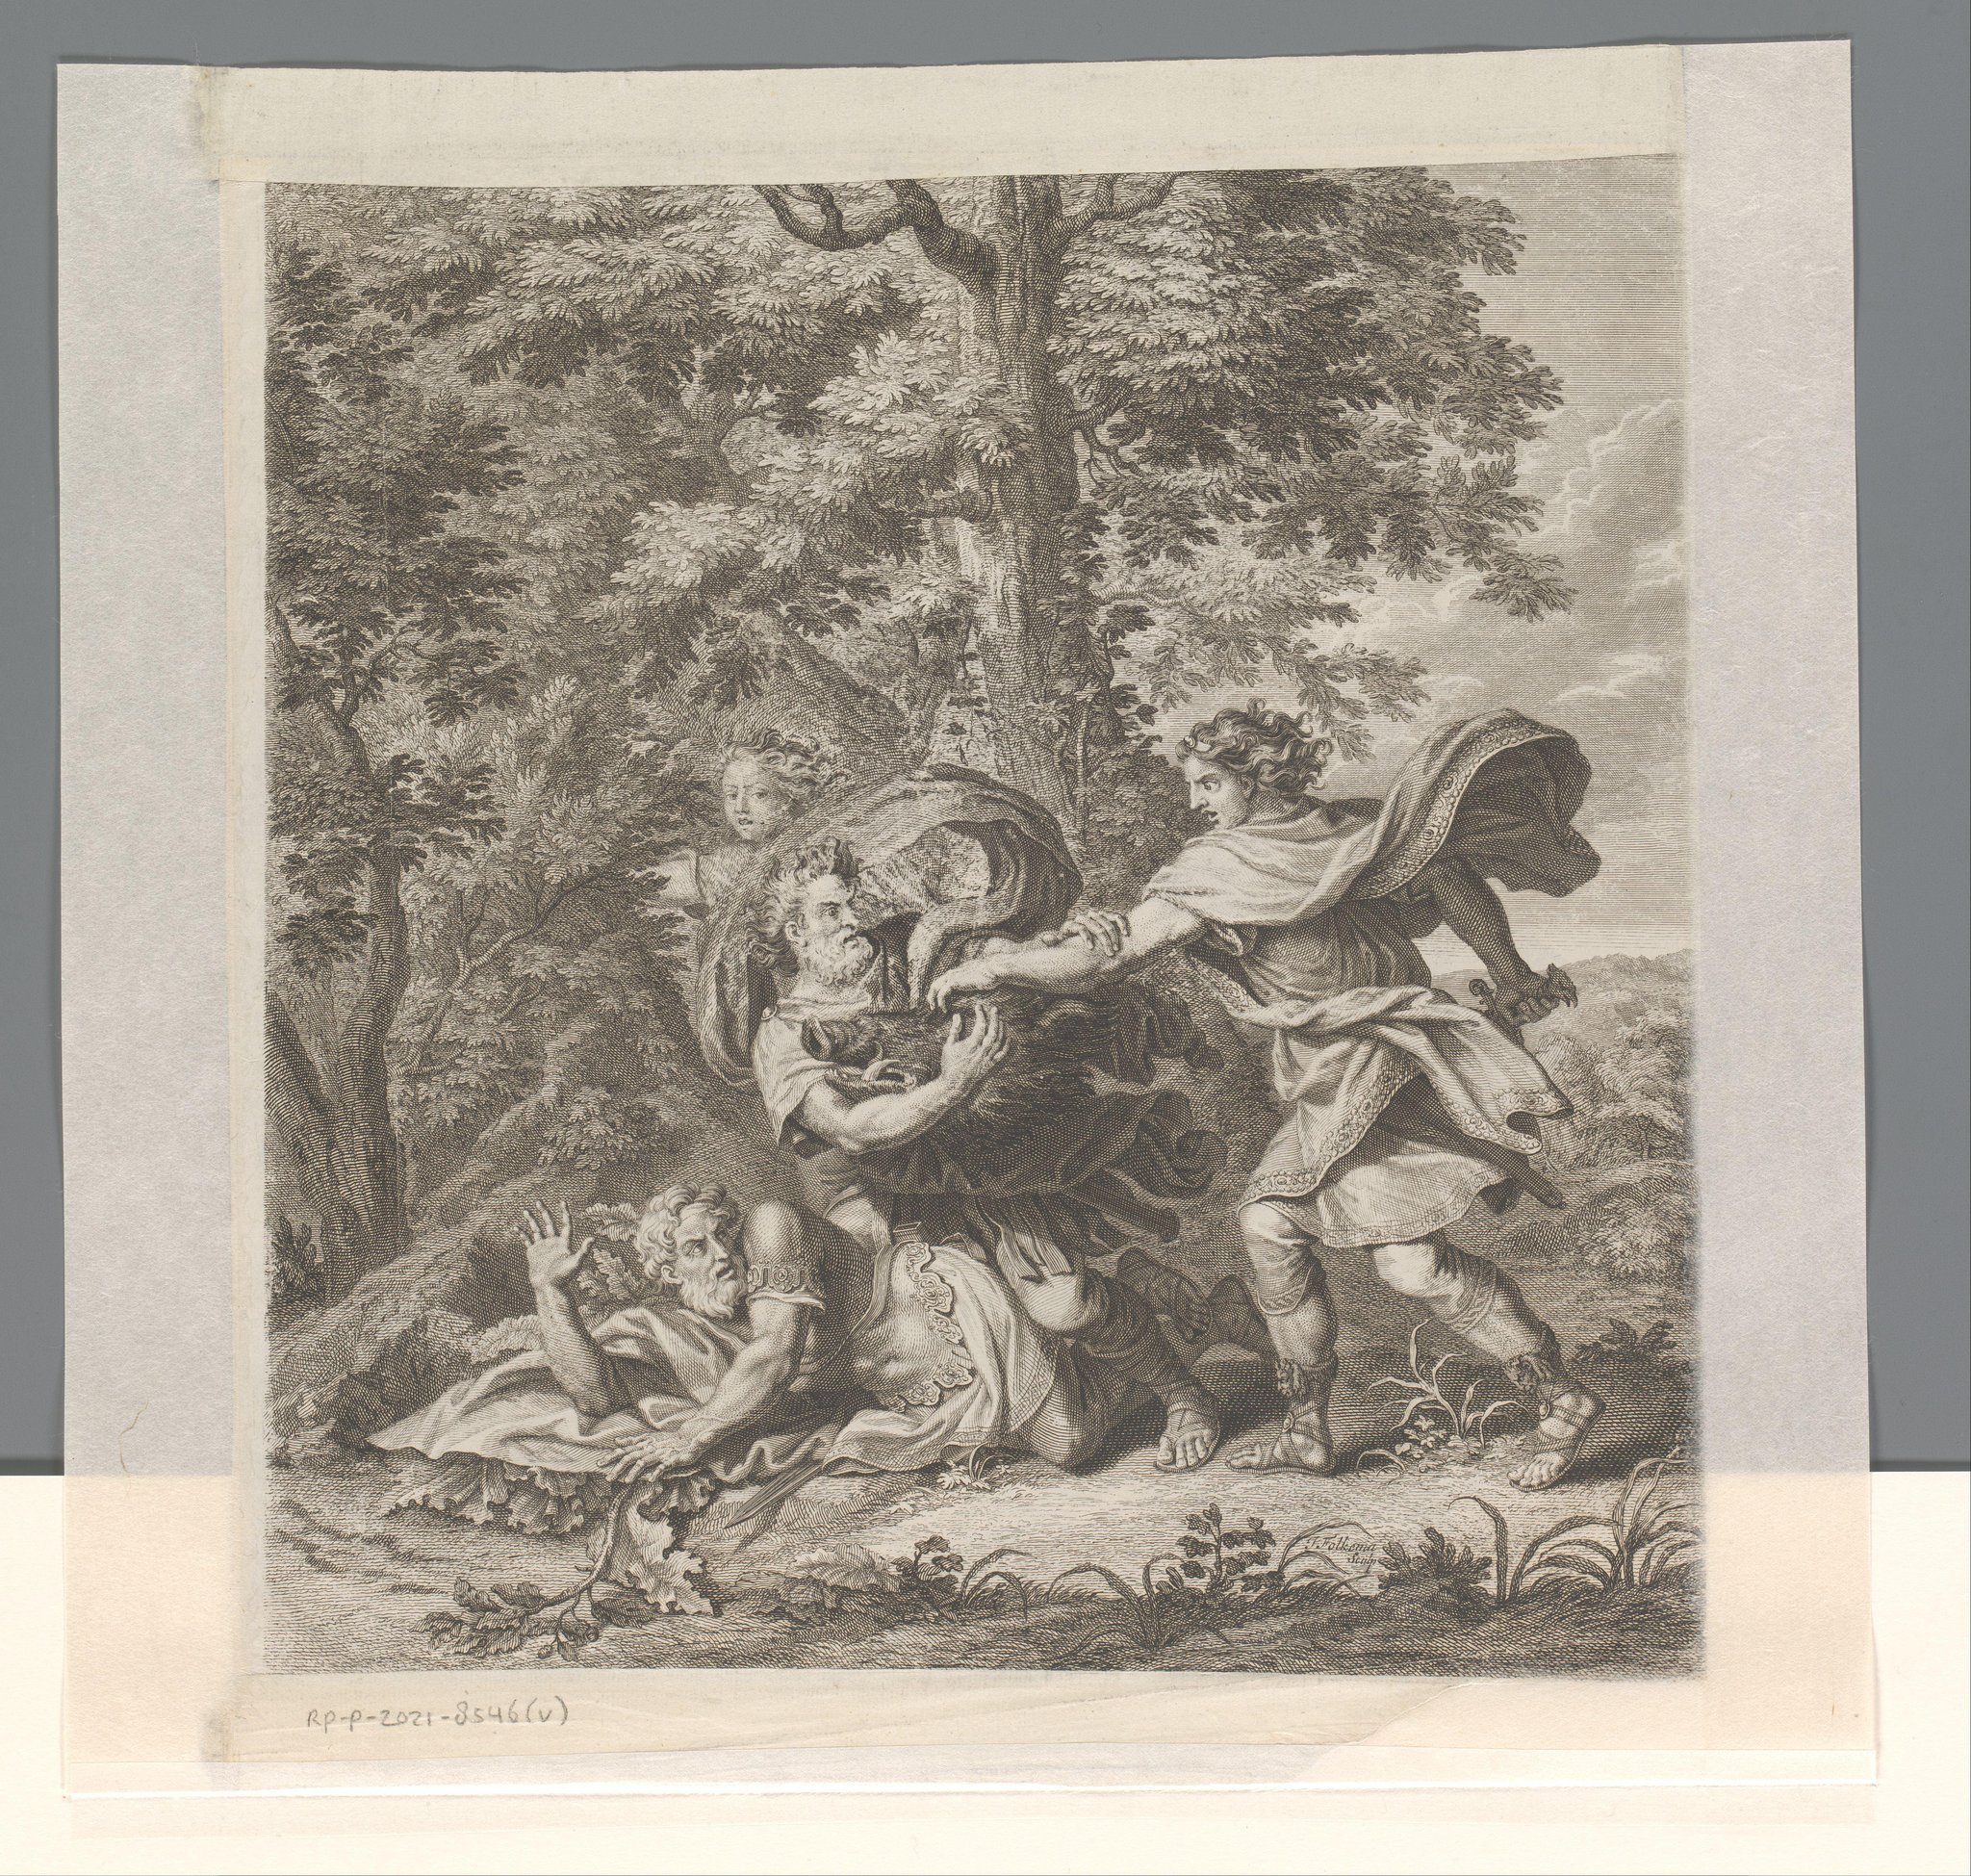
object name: print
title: Meleager strijdt met zijn ooms om de zwijnenkop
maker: jacob folkema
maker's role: draughtsman, print maker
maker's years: 1692-1767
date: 1712-1767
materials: paper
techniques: engraving, etching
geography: amsterdam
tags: the wild boar is killed, usually by meleager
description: Meleager heeft het Caledonische zwijn gedood en wil de zwijnenkop aan zijn geliefde Atalanta schenken. Hier zijn de beide ooms van Meleager het niet mee eens, wat leidt tot een twist.